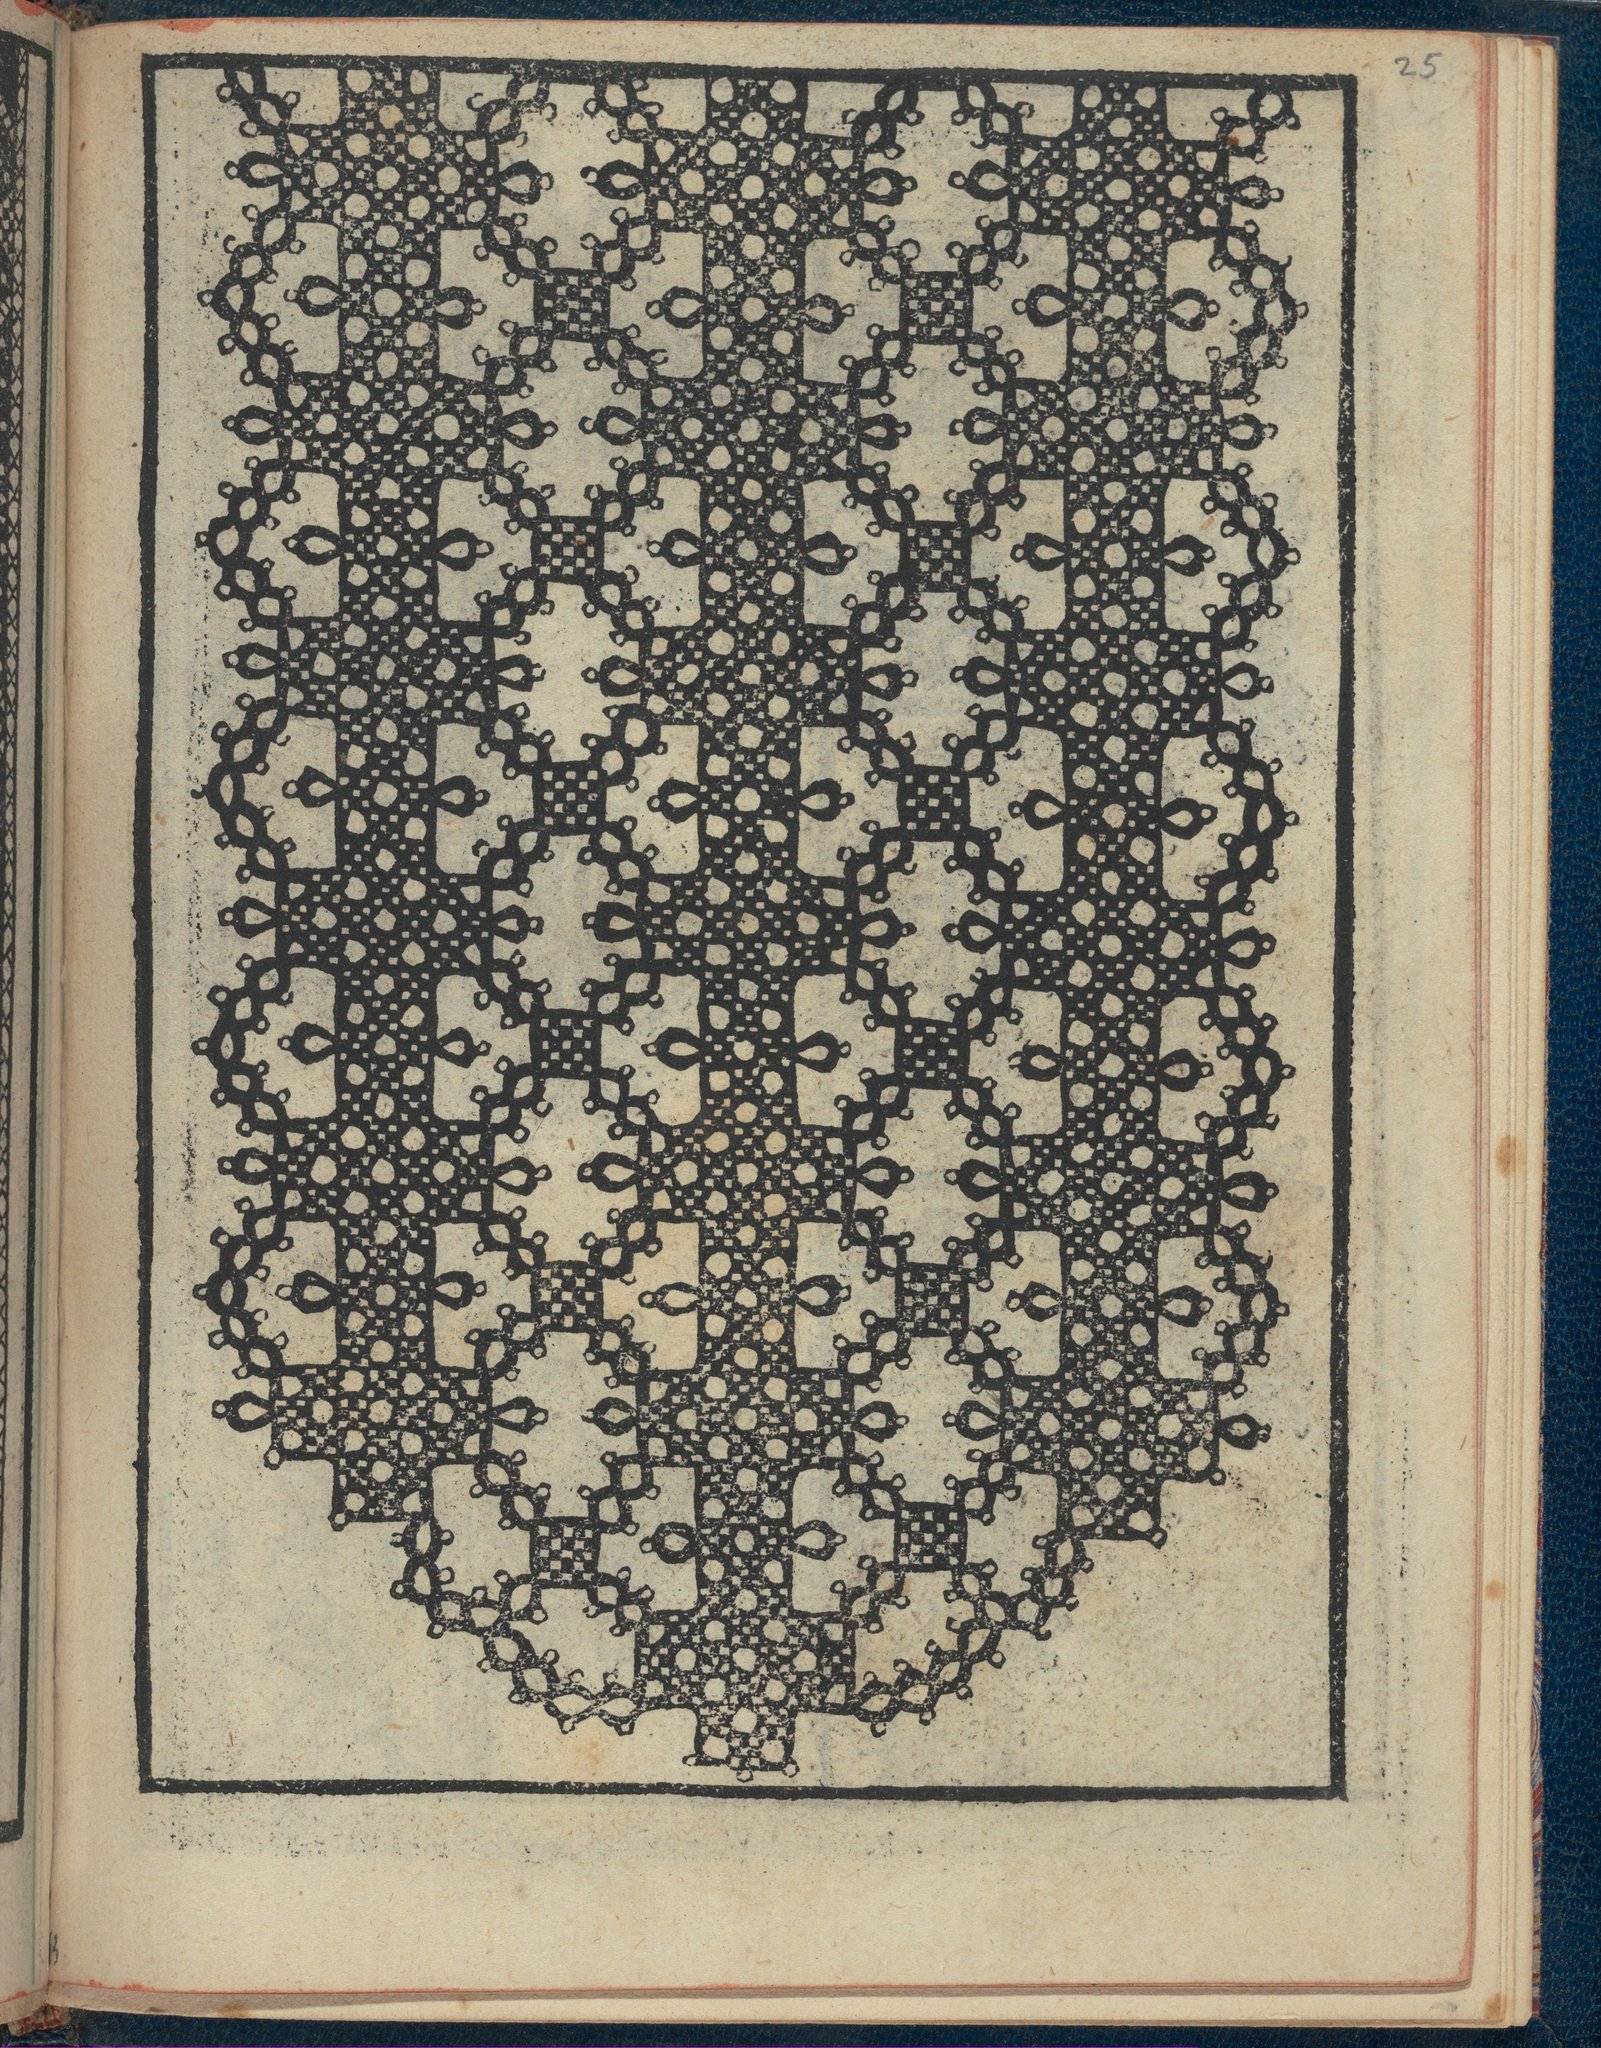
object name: book print ornament architecture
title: Le Pompe: Opera Nova, page 13 (recto)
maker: giovanni battista & marchio sessa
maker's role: publisher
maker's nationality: italian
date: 1557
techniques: woodcut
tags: ornament